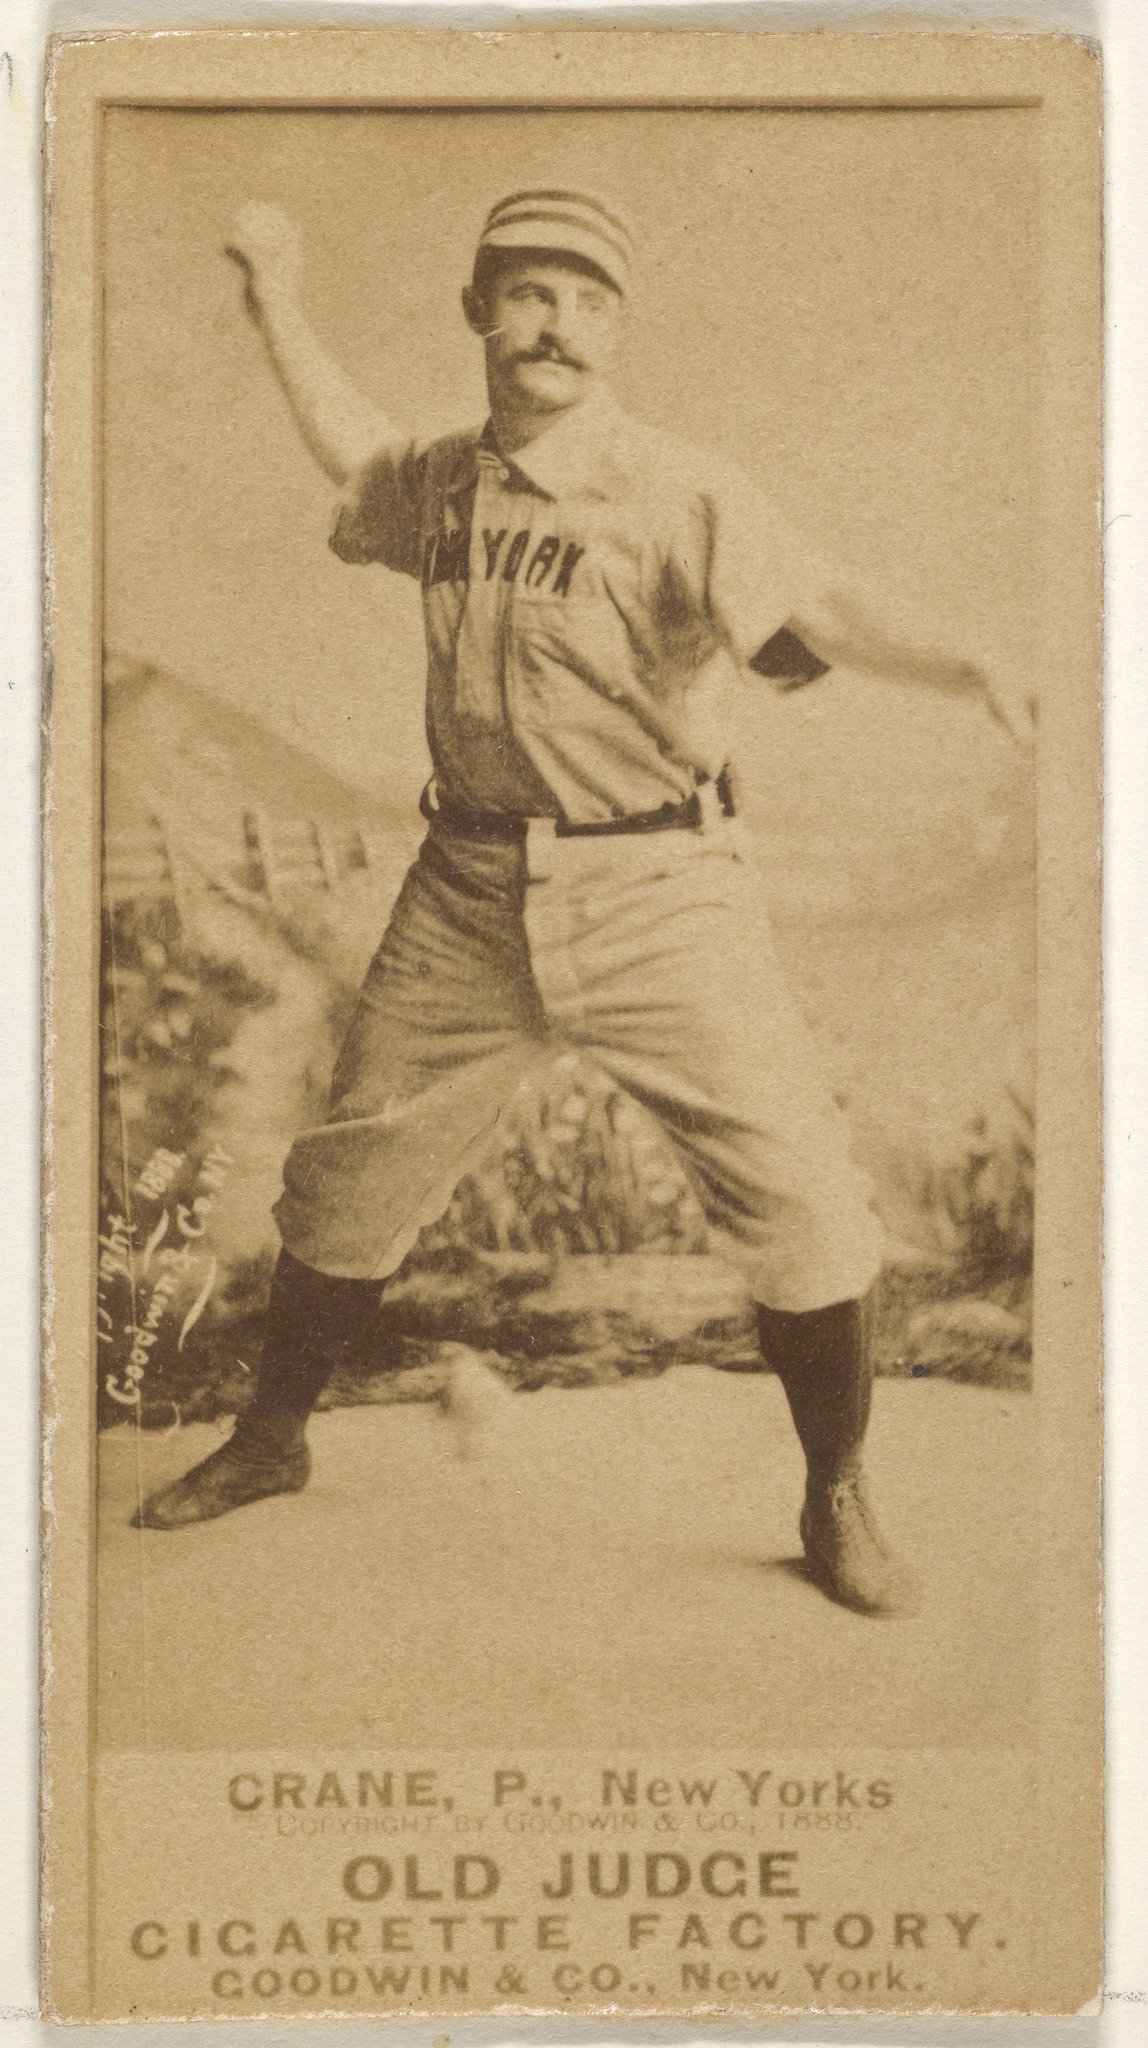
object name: baseball card, photograph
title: Ed Crane, Pitcher, New York, from the Old Judge series (N172) for Old Judge Cigarettes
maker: goodwin & company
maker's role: publisher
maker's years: 1850-1950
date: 1888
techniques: albumen silver print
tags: men,portraits,baseball,athletes